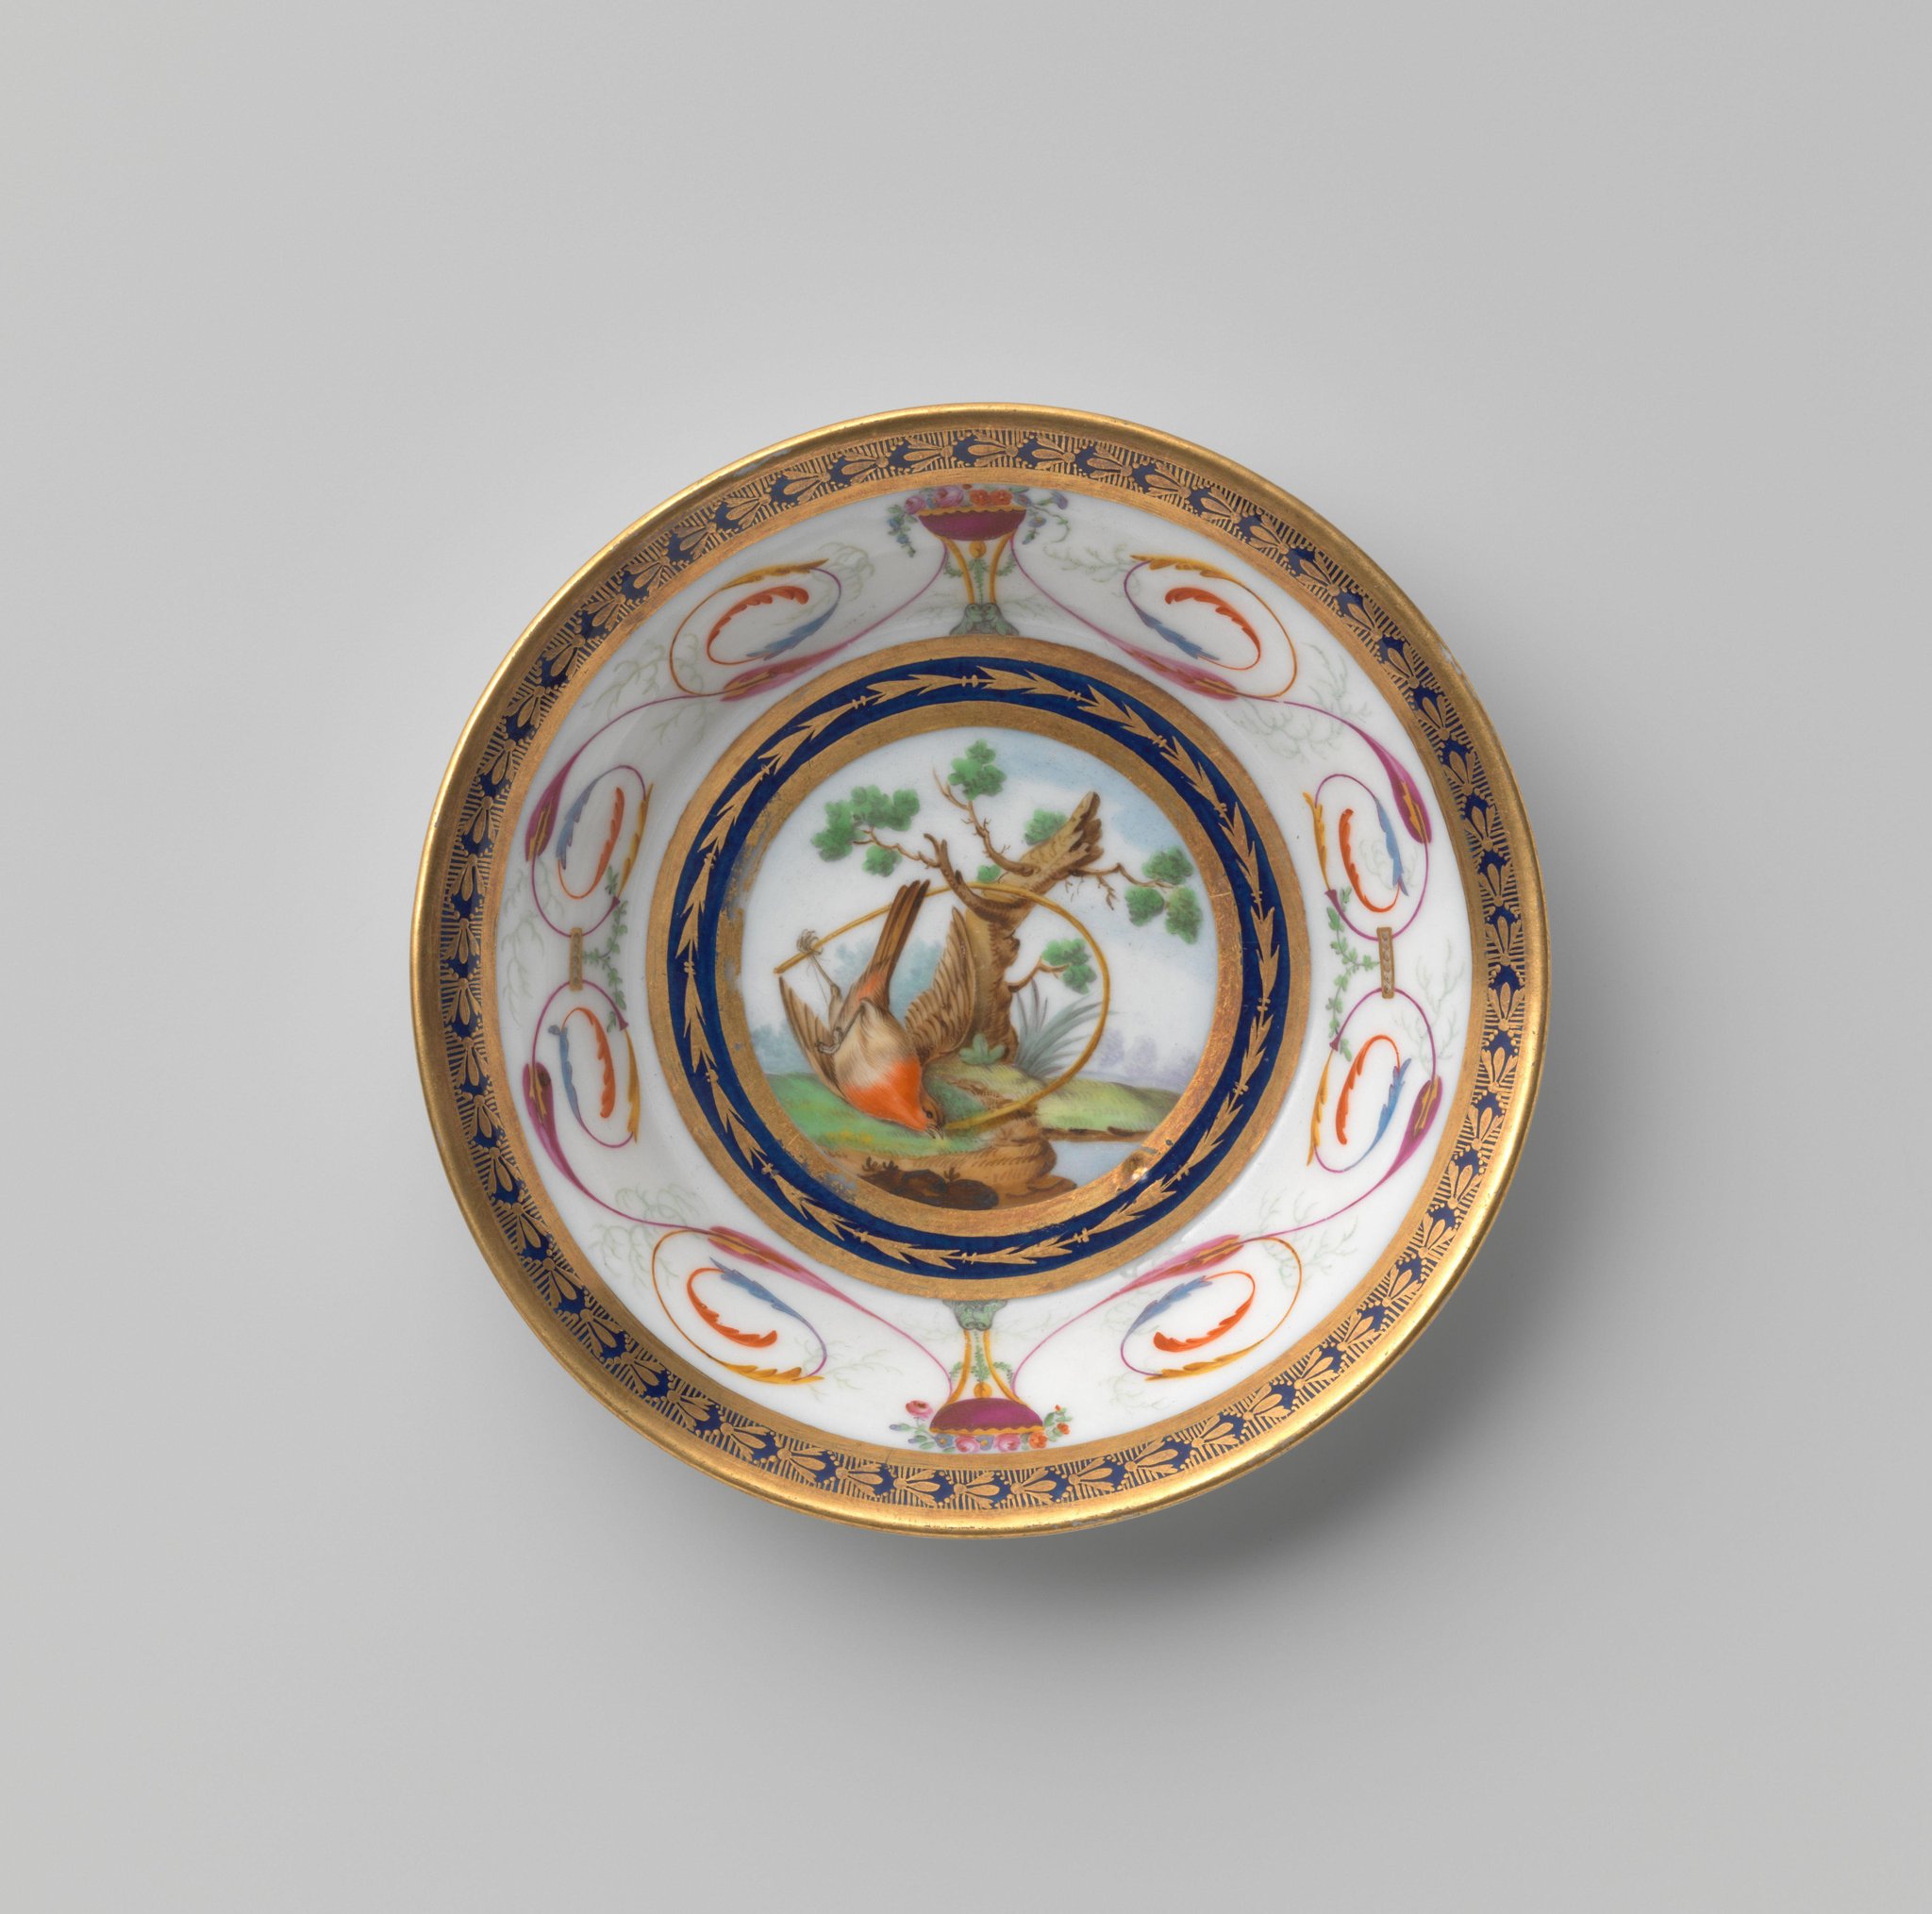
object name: platter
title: Saucer with a bird in a landscape, foliate scrolls and garlands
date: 1790-1800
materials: cobalt, glaze, gold, paint, porcelain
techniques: firing, gilding, turning, vitrification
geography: faubourg saint-denis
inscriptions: mark: ‘gekroonde CP’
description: Schotel van porselein met een rechte wand, beschilderd in onderglazuur blauw en op het glazuur emailkleuren en goud. Op het plat een medaillon van goud tegen een blauwe achtergrond; de binnenrand met eenzelfde band. In het medaillon een vogel in een landschap. Op de wand bladranken met guirlandes en bloemenvasen. Gouden rand. Gemerkt op de onderzijde met de gekroonde CP.